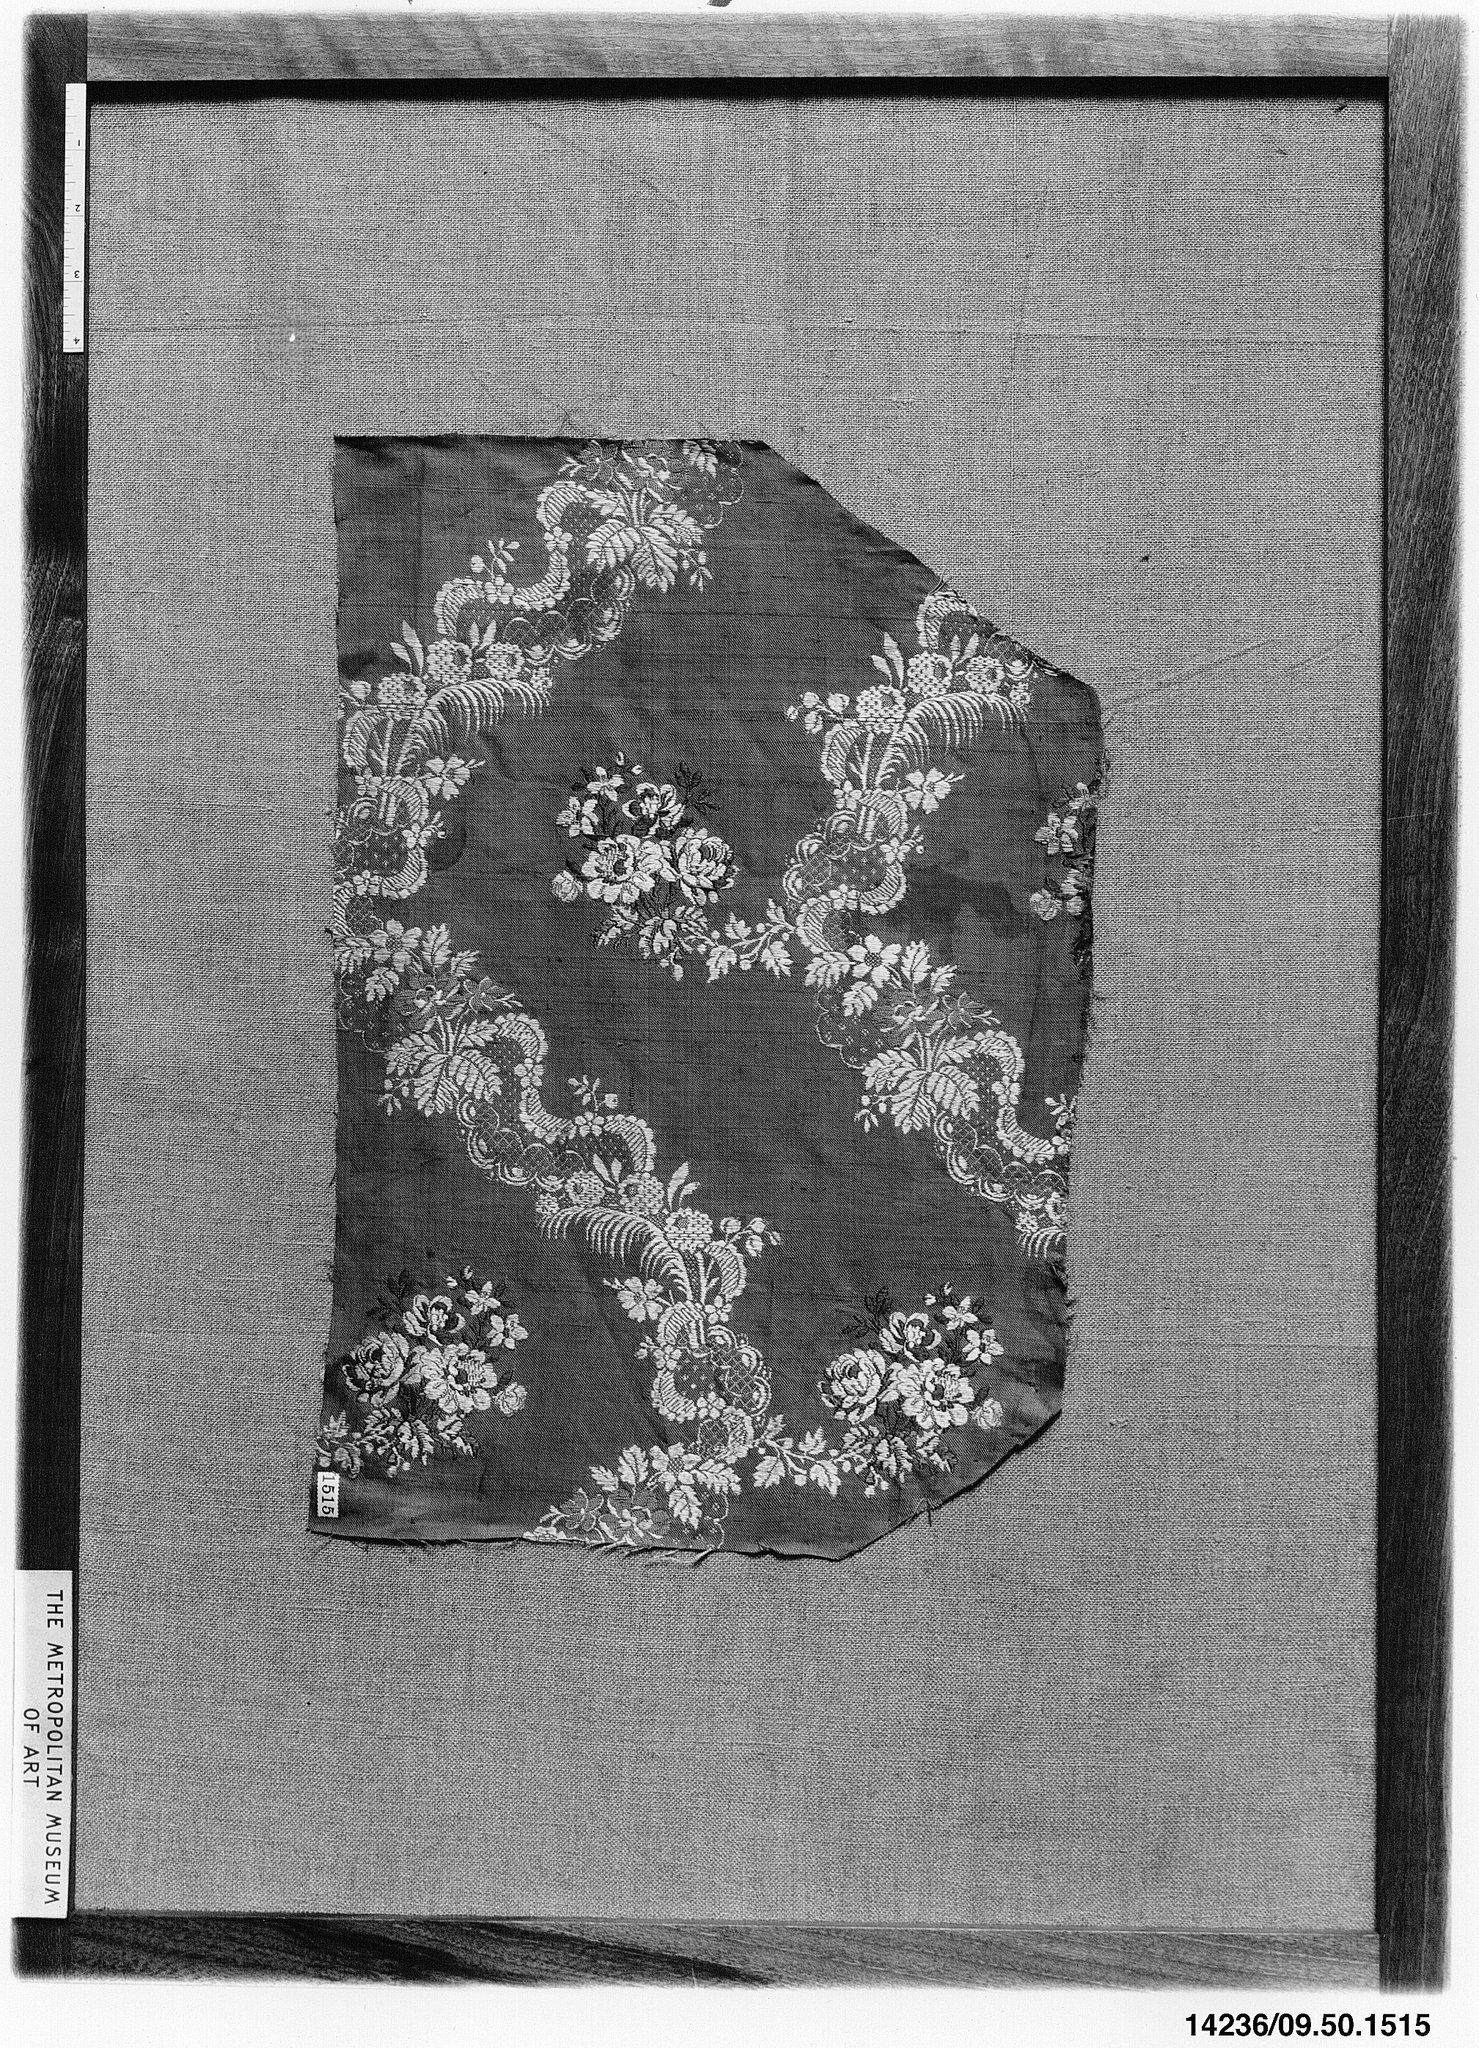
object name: piece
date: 1765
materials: silk